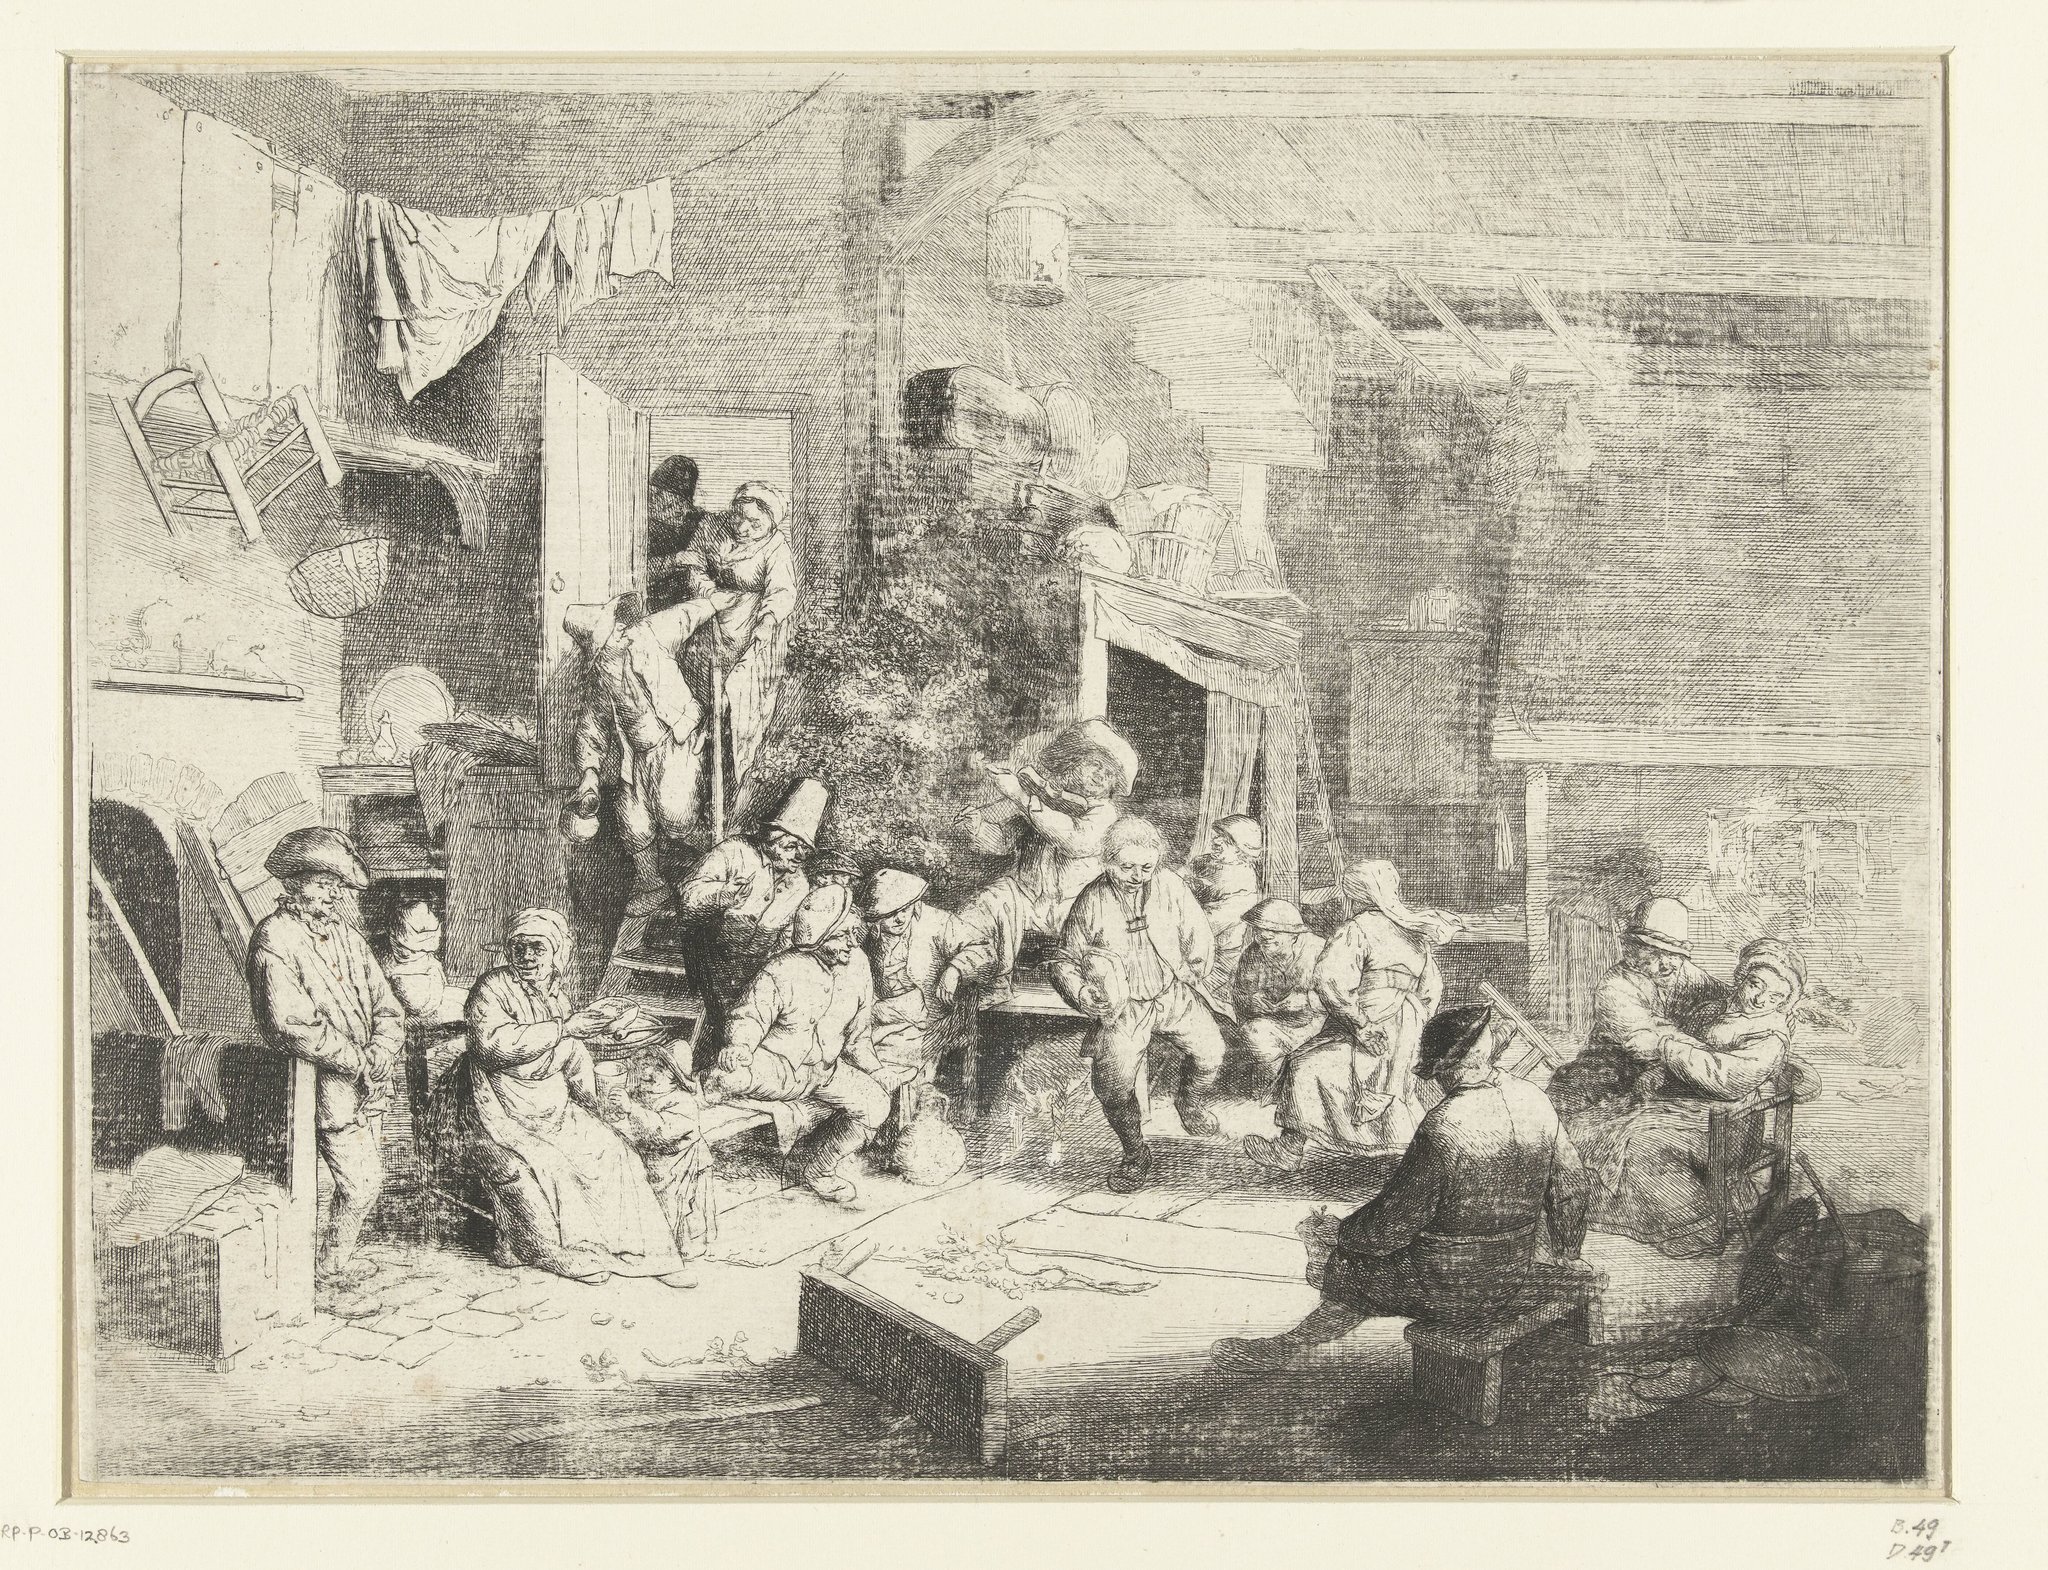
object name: print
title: Dans in de herberg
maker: adriaen van ostade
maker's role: draughtsman, painter, print maker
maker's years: 1610-1685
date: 1650-1654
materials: paper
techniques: etching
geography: haarlem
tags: inn, coffee-house, public house, etc., one pair dancing; man and woman dancing as a couple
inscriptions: collector's mark: Lugt 240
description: Een groep mensen in een rommelige herberg, te midden van hen dansen een man en een vrouw op de muziek van een vedelspeler. Geheel rechts omhelst een man een zittende vrouw. Drie personen komen de herberg binnen via een trap.